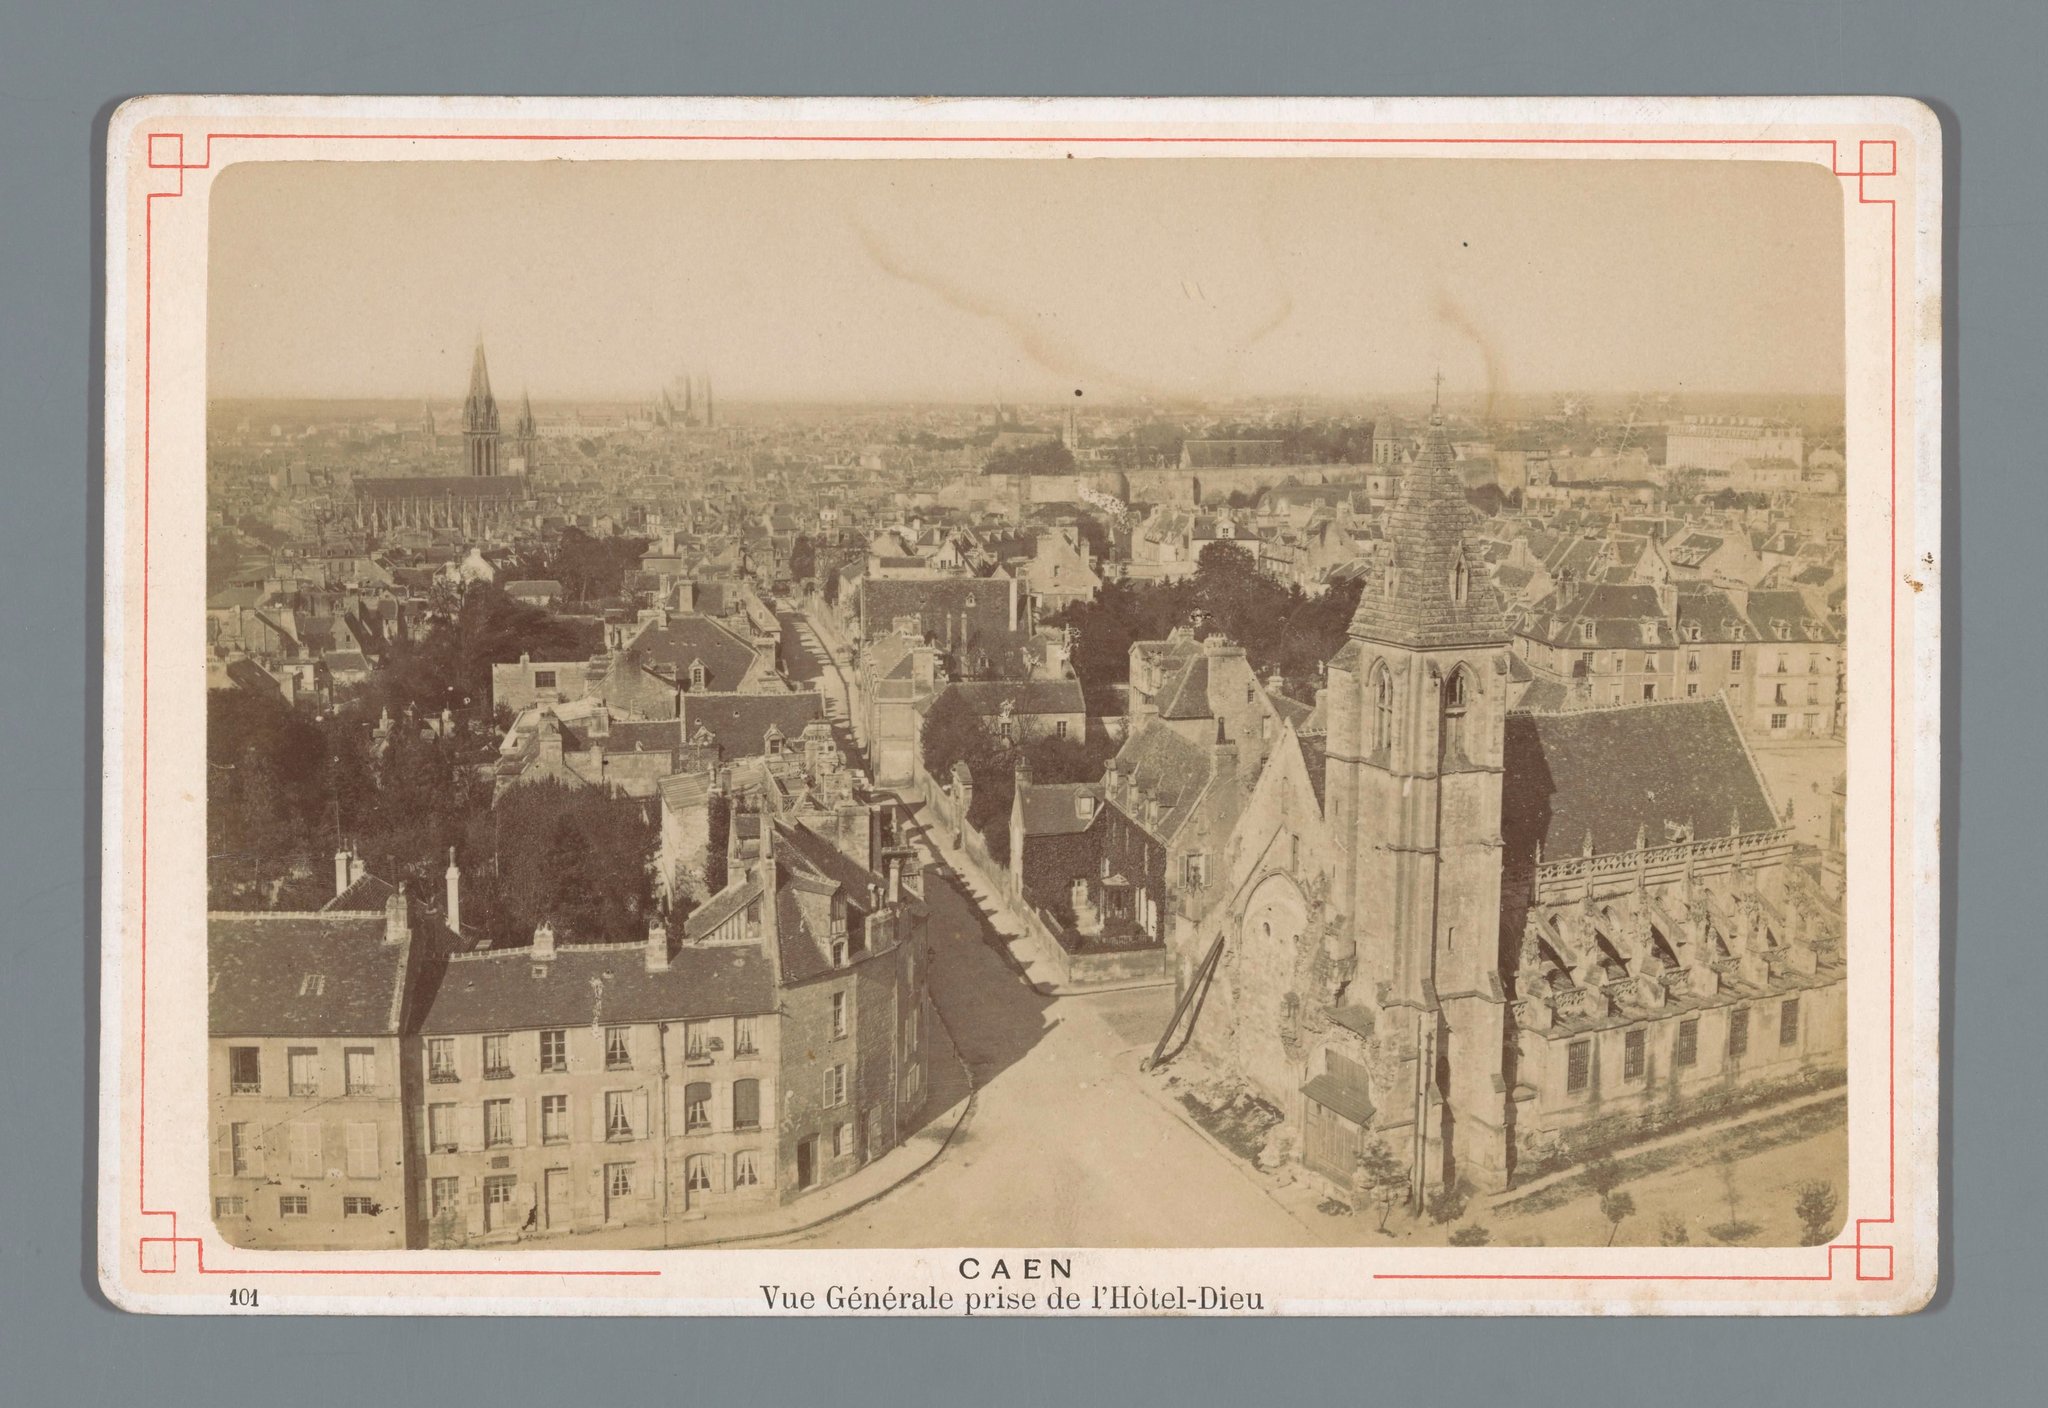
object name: photograph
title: Gezicht op Caen genomen vanaf het l'Hôtel-Dieu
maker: Anonymous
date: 1893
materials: cardboard, photographic support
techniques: albumen print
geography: caen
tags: city-view in general; 'veduta'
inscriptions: number: ‘101’, date: ‘13 Août 1893’